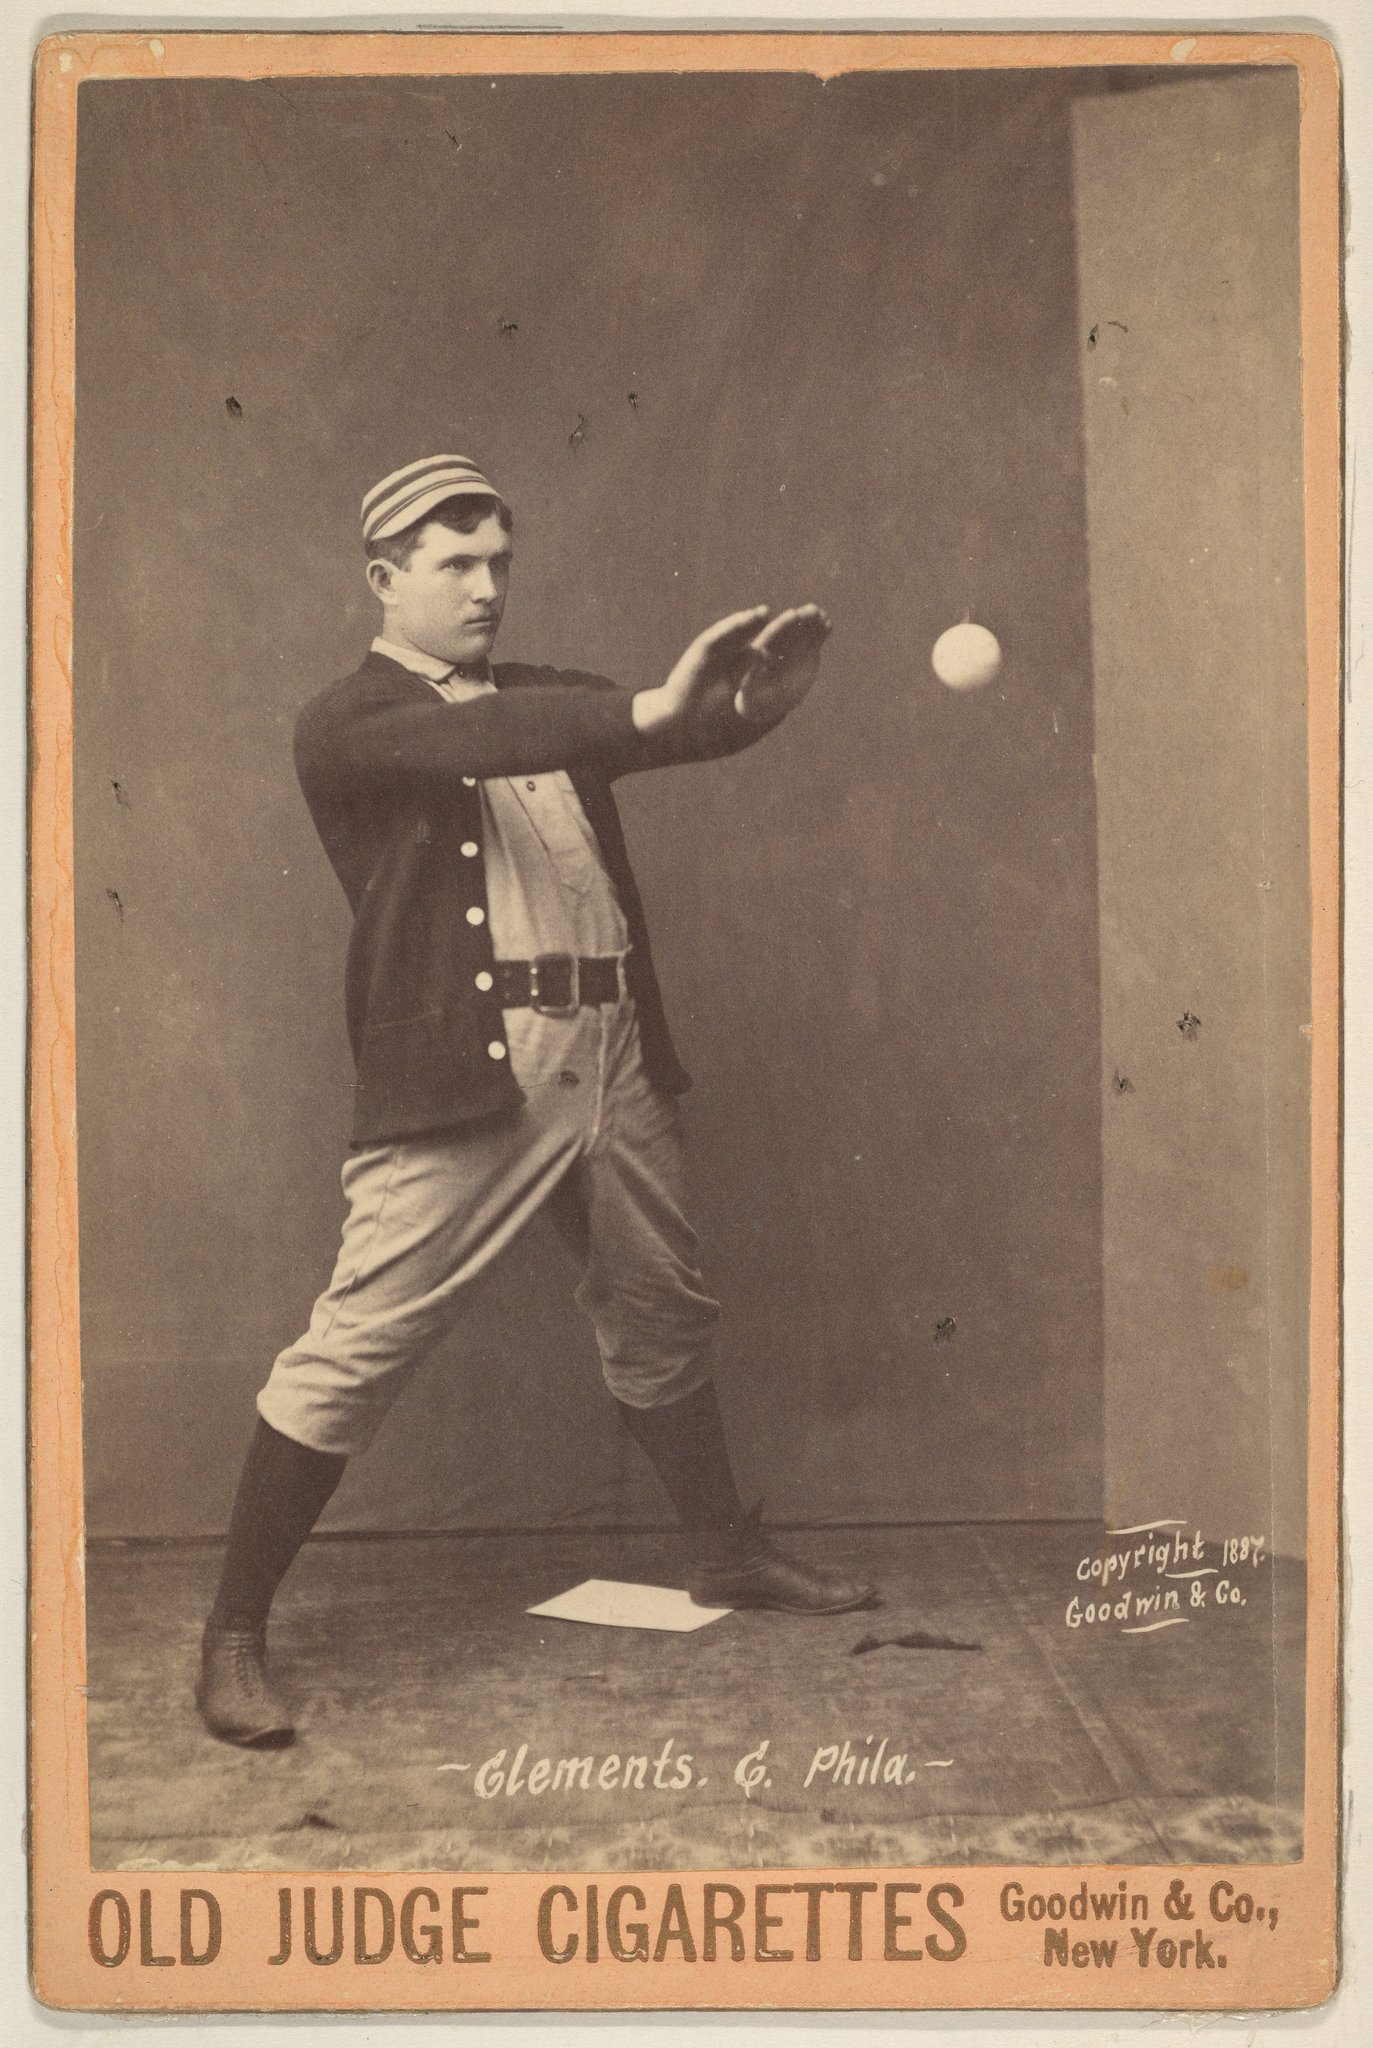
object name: baseball card, photograph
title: Clements, Catcher, Philadelphia, from the series Old Judge Cigarettes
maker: goodwin & company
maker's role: publisher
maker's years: 1850-1950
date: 1887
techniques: albumen silver print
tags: men,portraits,baseball,athletes